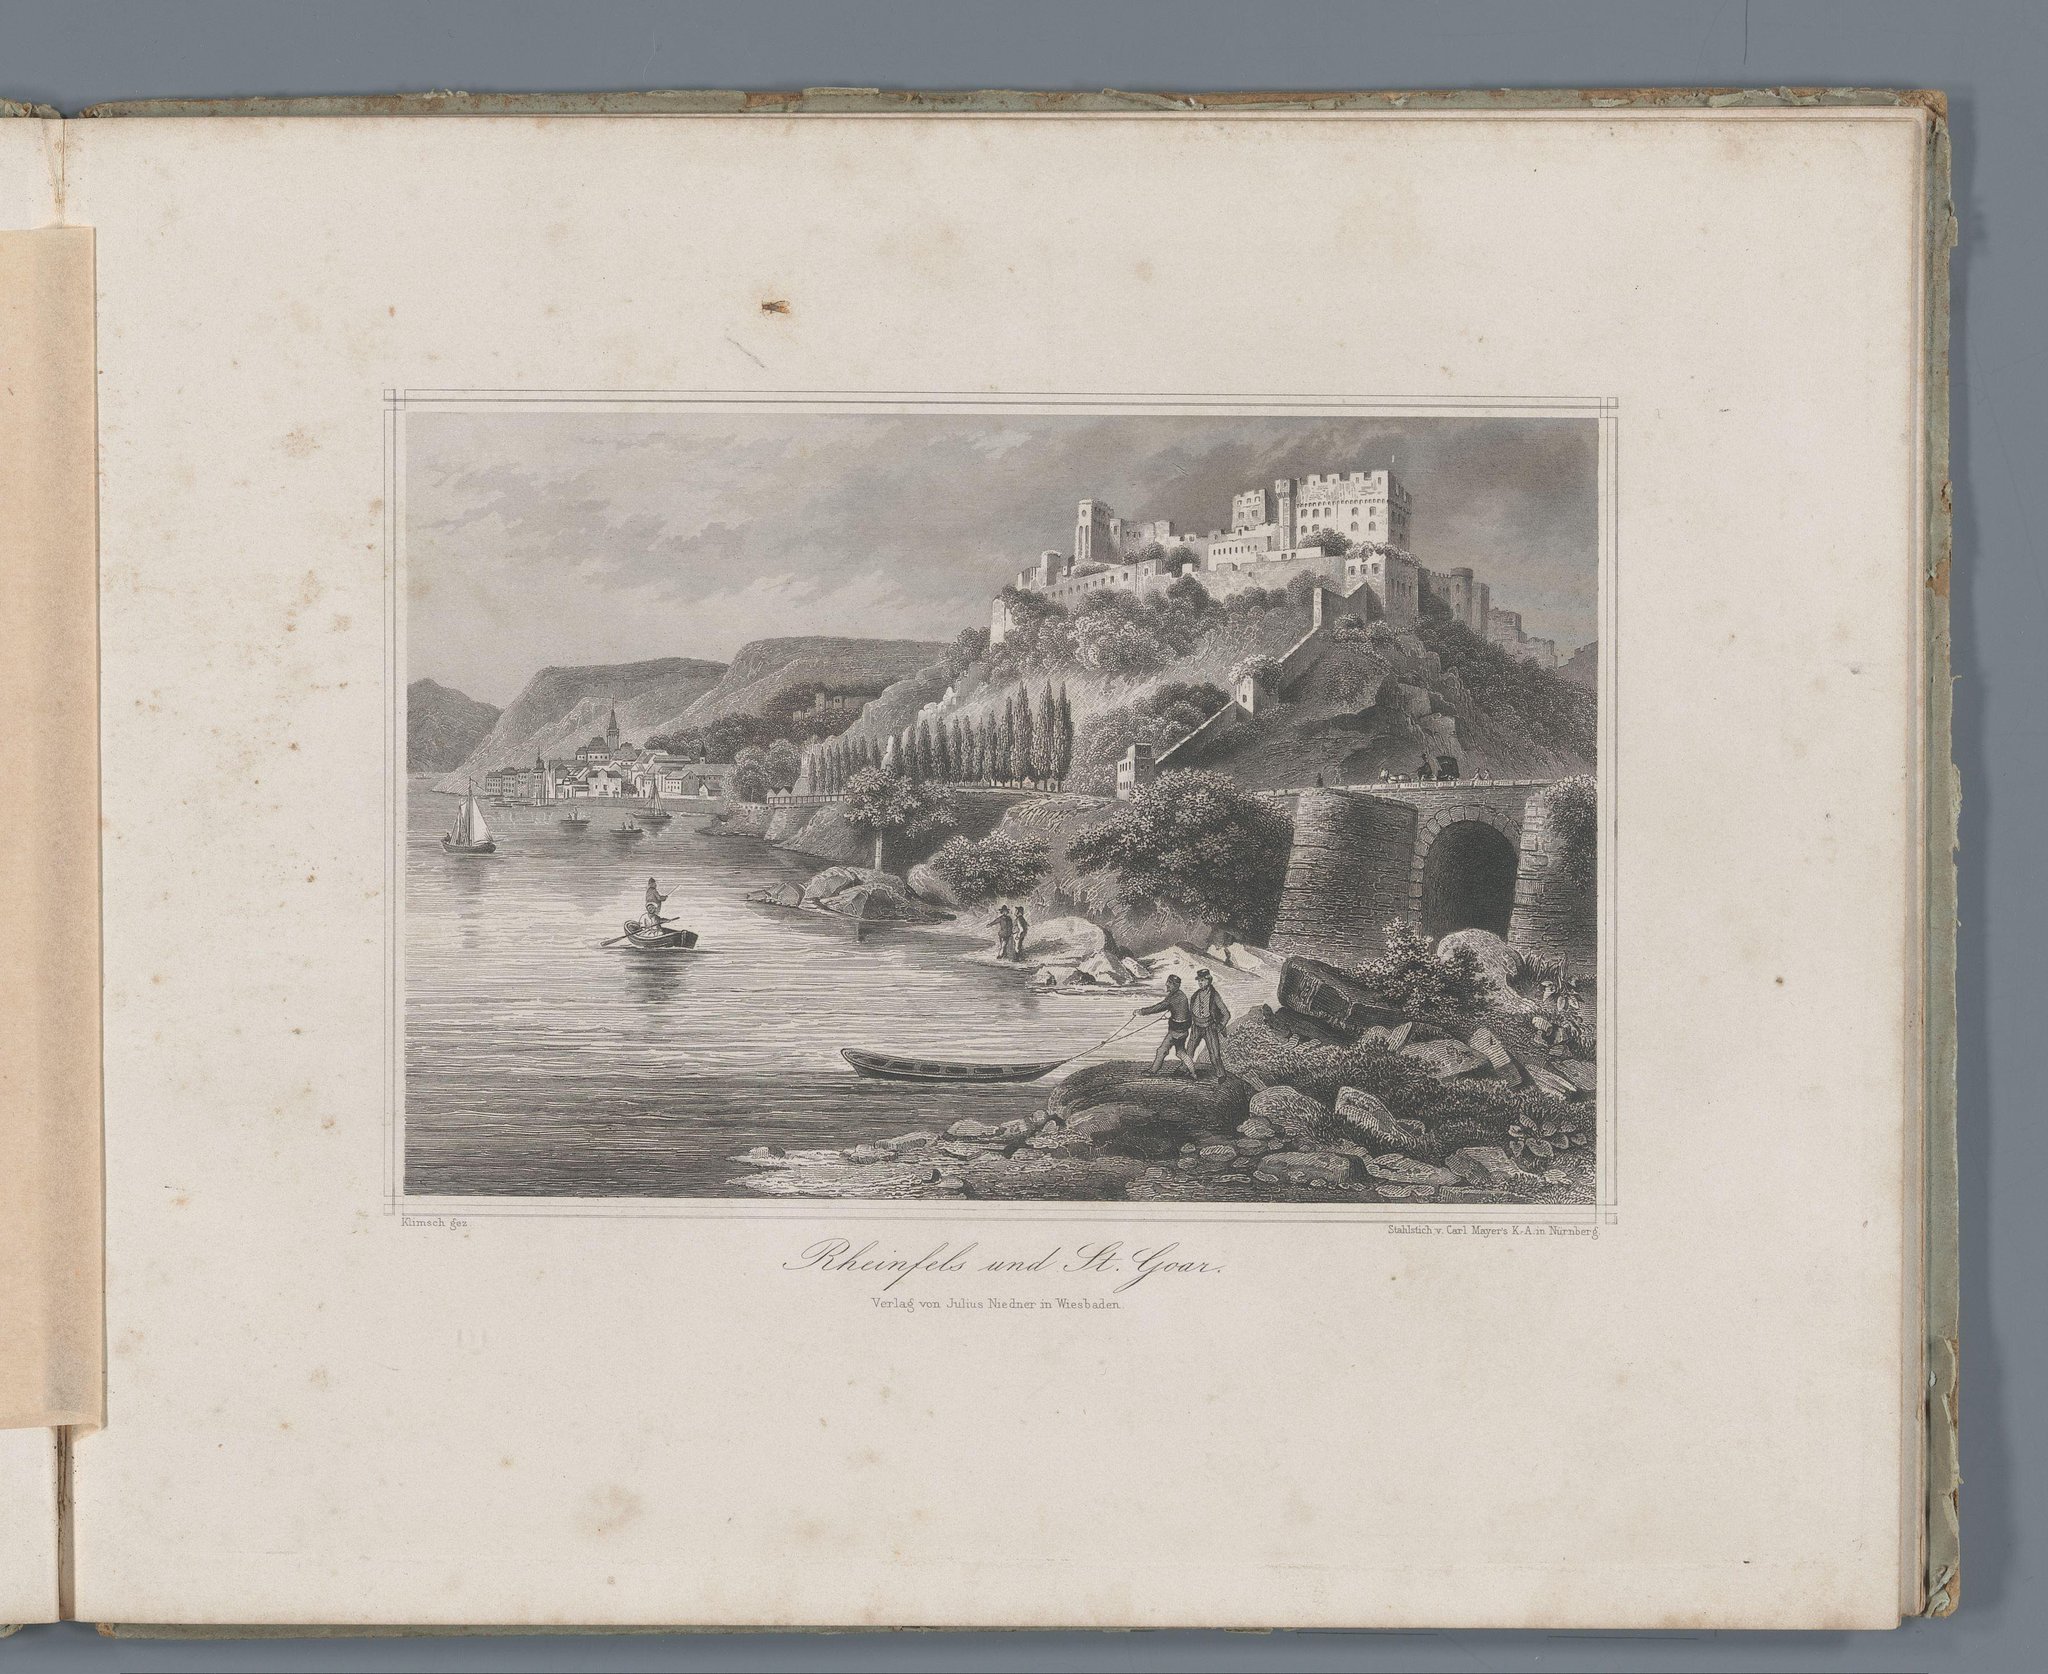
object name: print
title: Zwölf der schönsten Ansichten des Rheins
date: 1822-1868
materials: paper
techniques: engraving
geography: wiesbaden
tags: prospect of village, silhouette of village, castle, river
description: Deze prent maakt deel uit van een album met twaalf prenten.